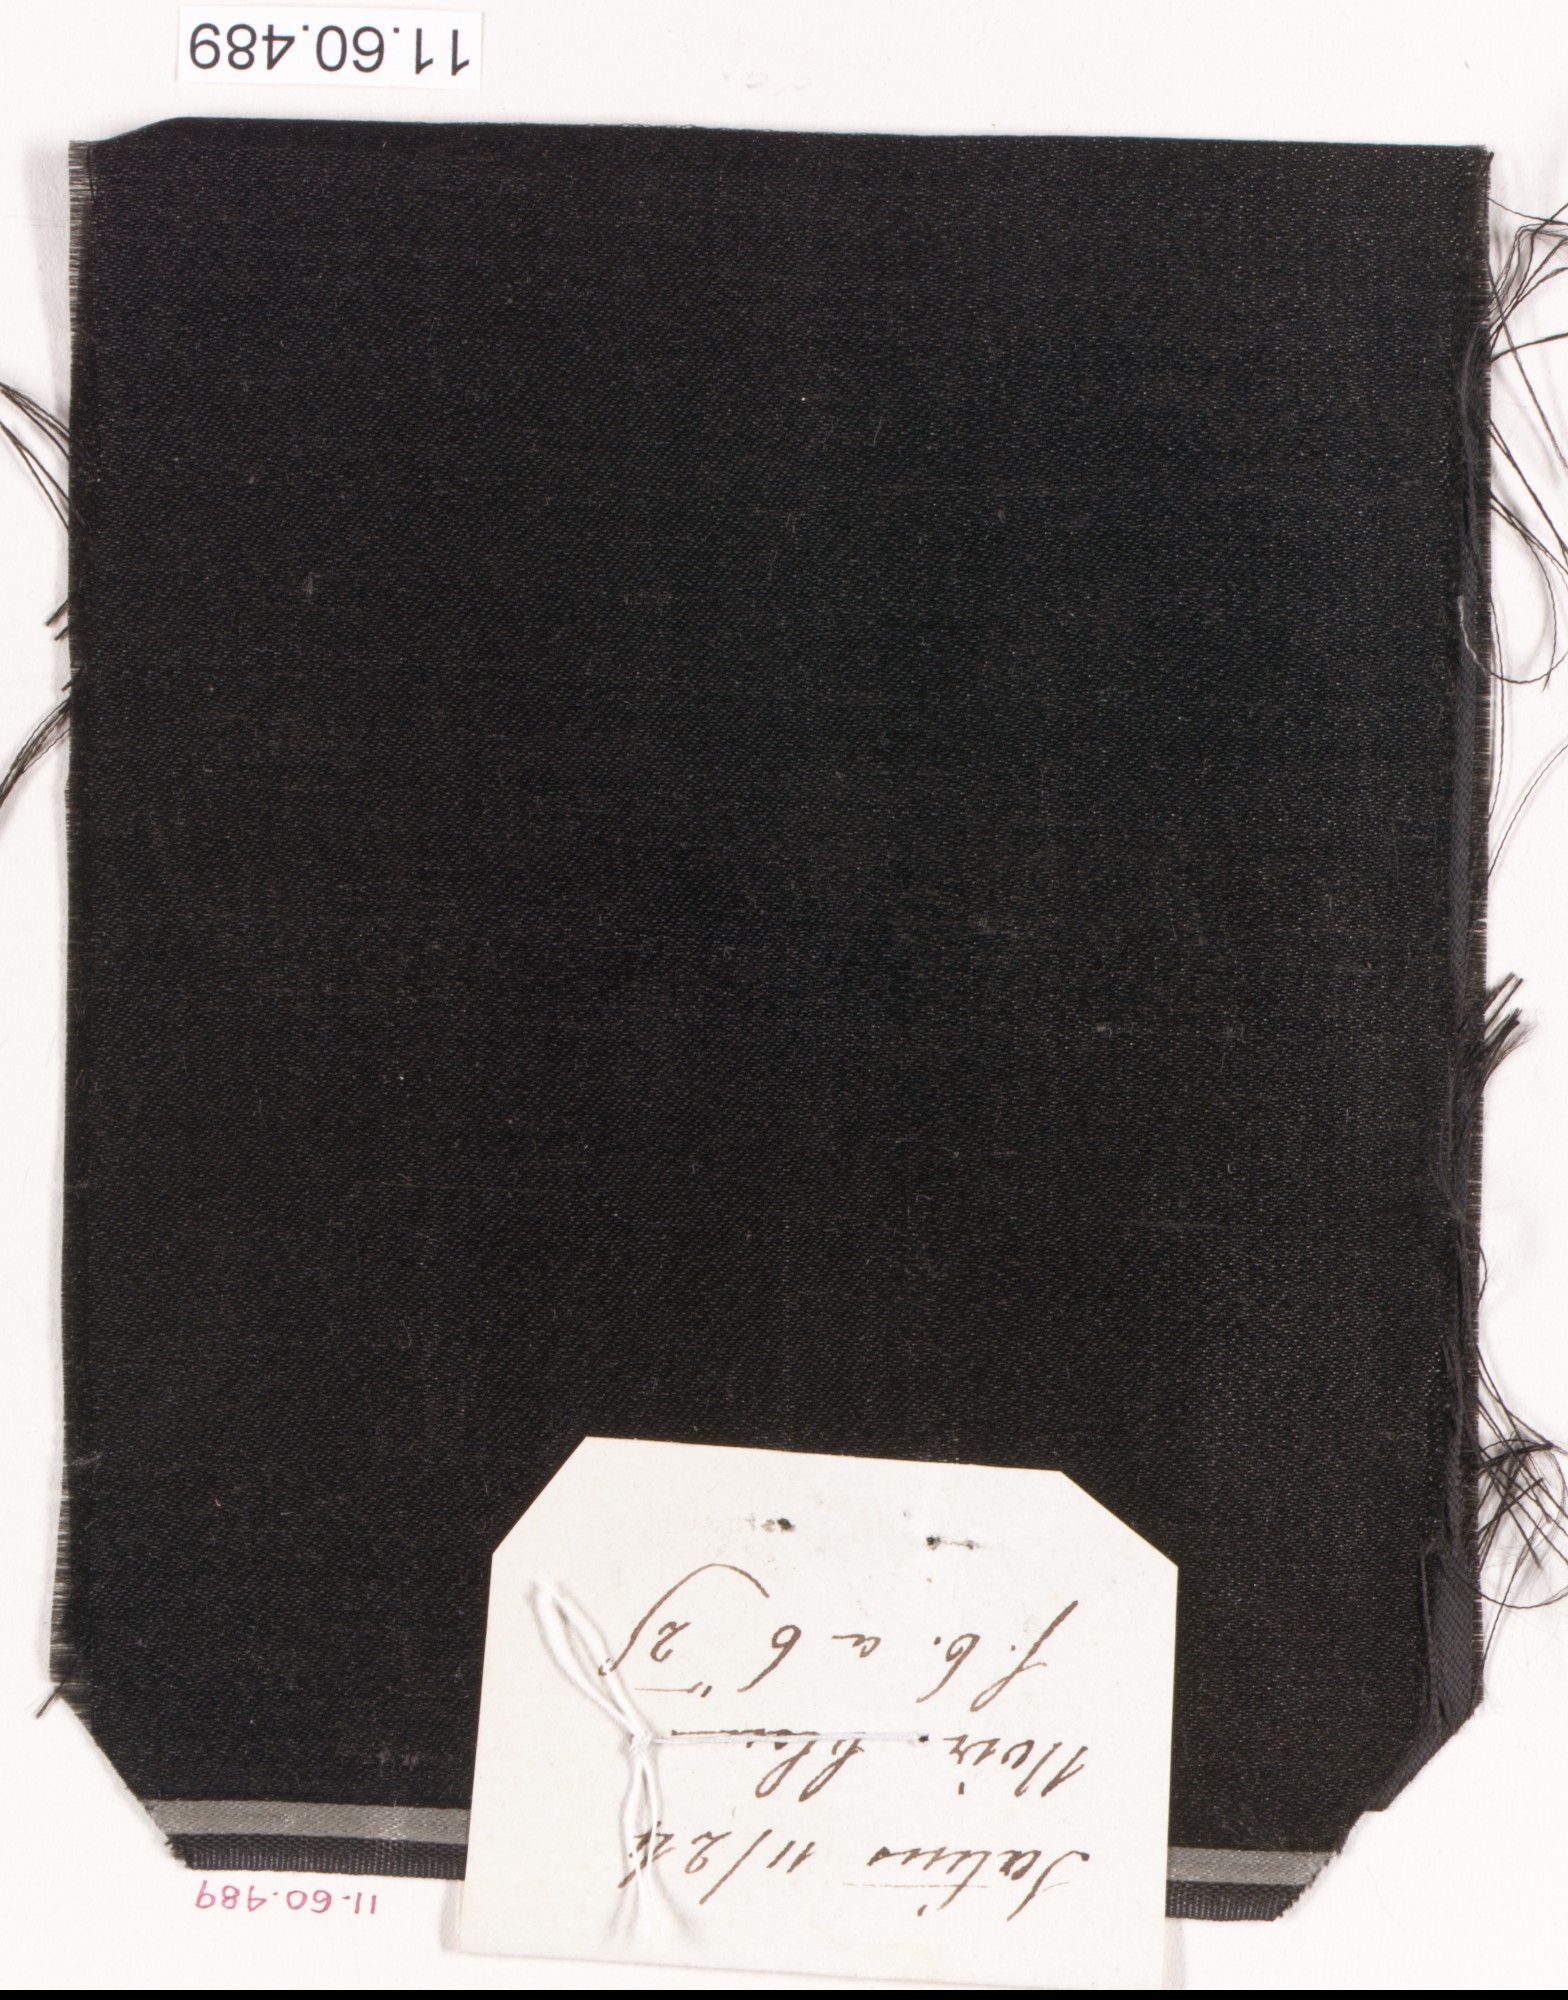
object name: sample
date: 1801-1850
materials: silk